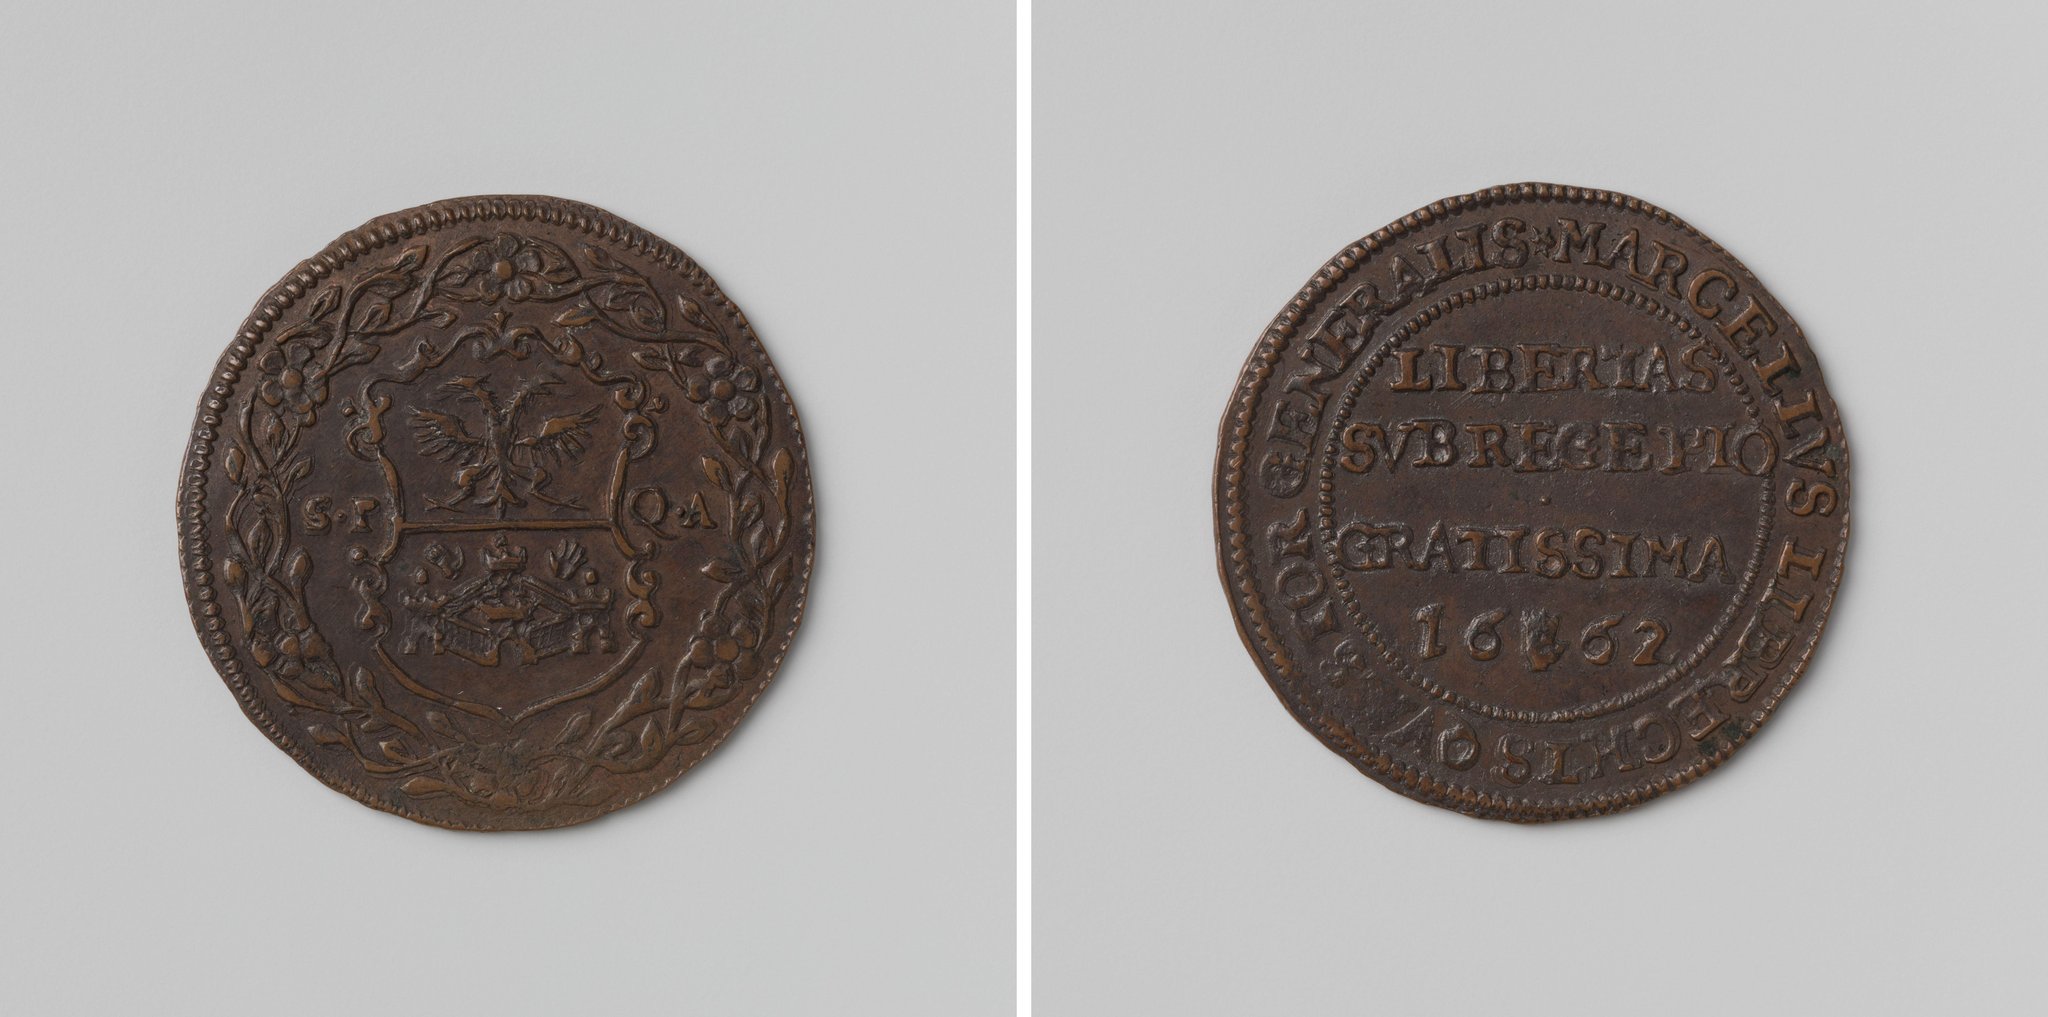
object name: jeton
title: Marcellus Librechts, rentmeester-generaal van de stad Antwerpen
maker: Anonymous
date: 1662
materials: copper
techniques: striking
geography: antwerp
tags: antwerp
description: Koperen penning. Voorzijde: wapenschild in cartouche tussen letters S.P.Q.A. binnen krans van bladeren en bloemen. Keerzijde: opschrift binnen omschrift